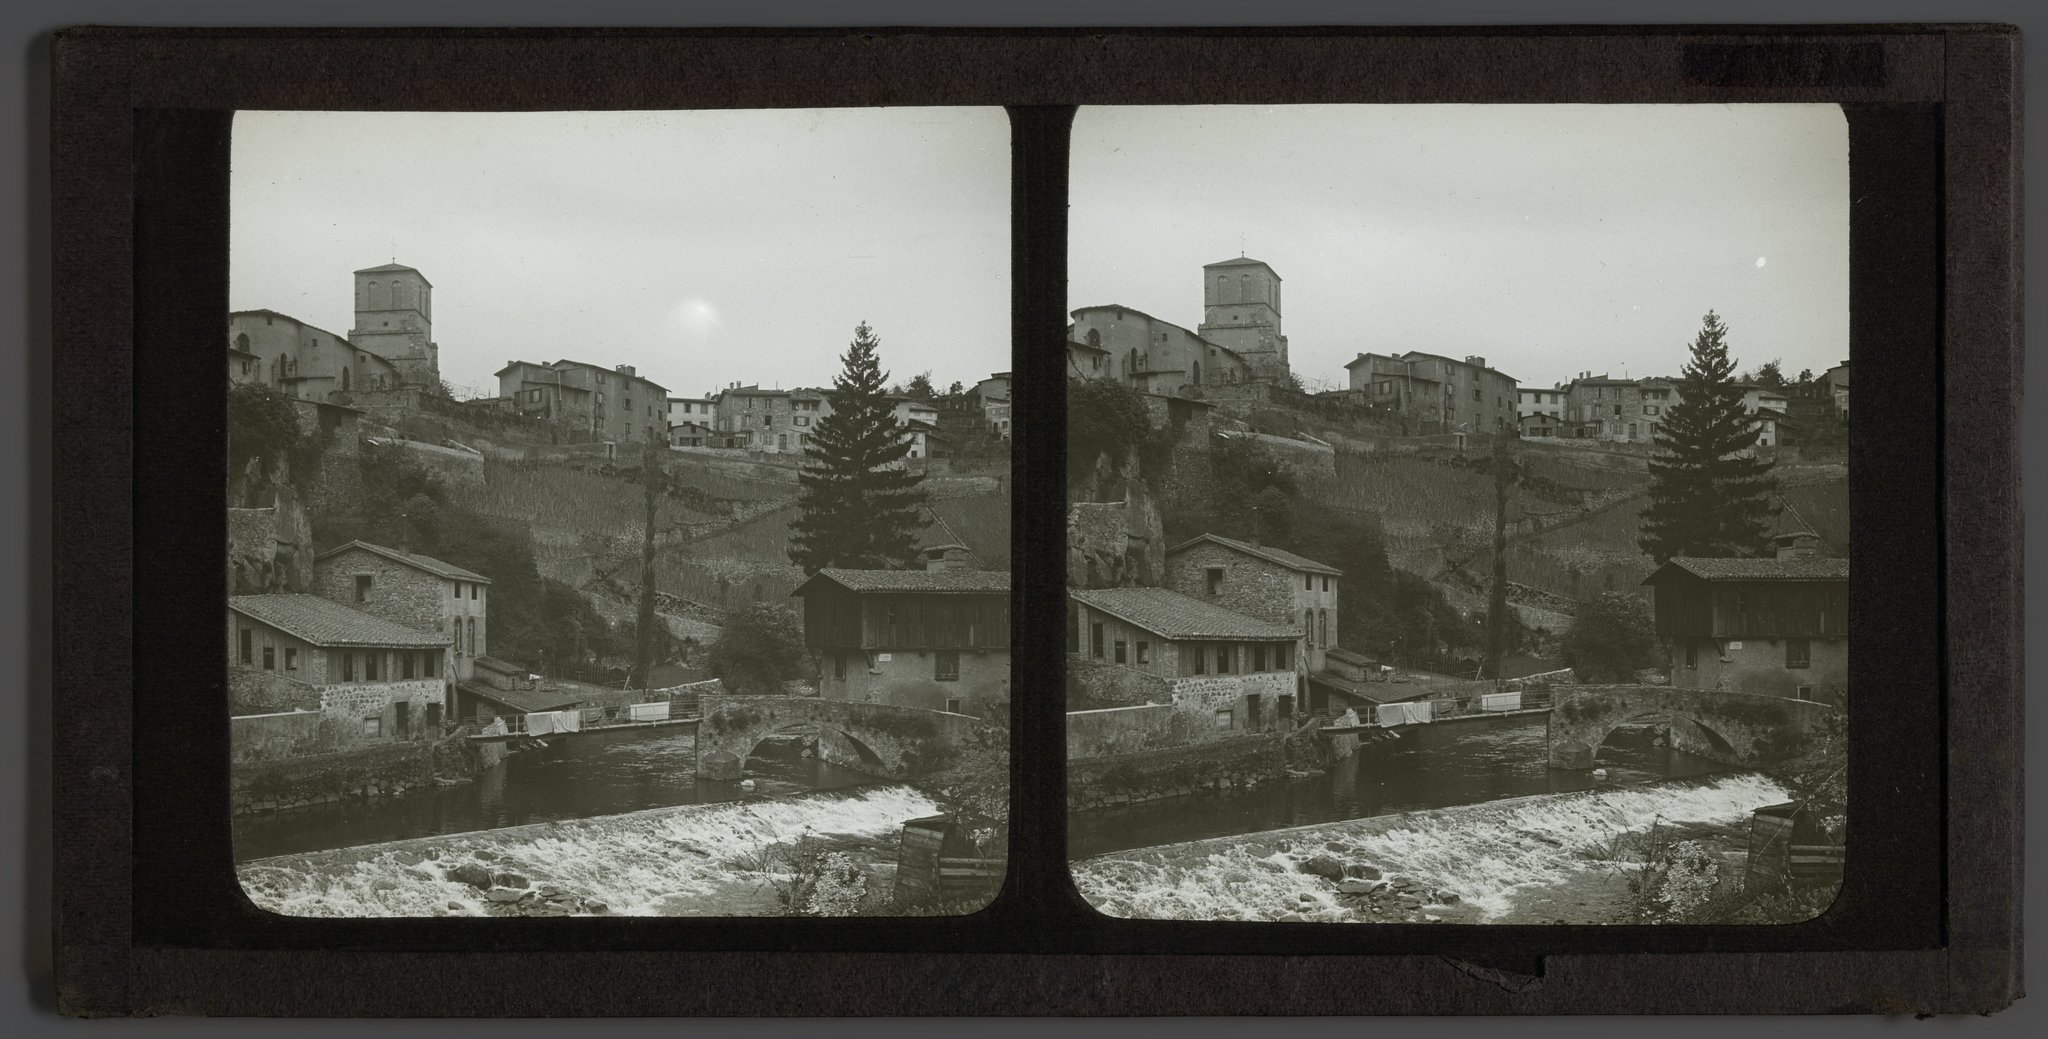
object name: stereoscopic photograph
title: Gezicht op Thiers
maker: Anonymous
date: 1860-1900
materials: glass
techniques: slide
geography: thiers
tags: city-view in general; 'veduta'